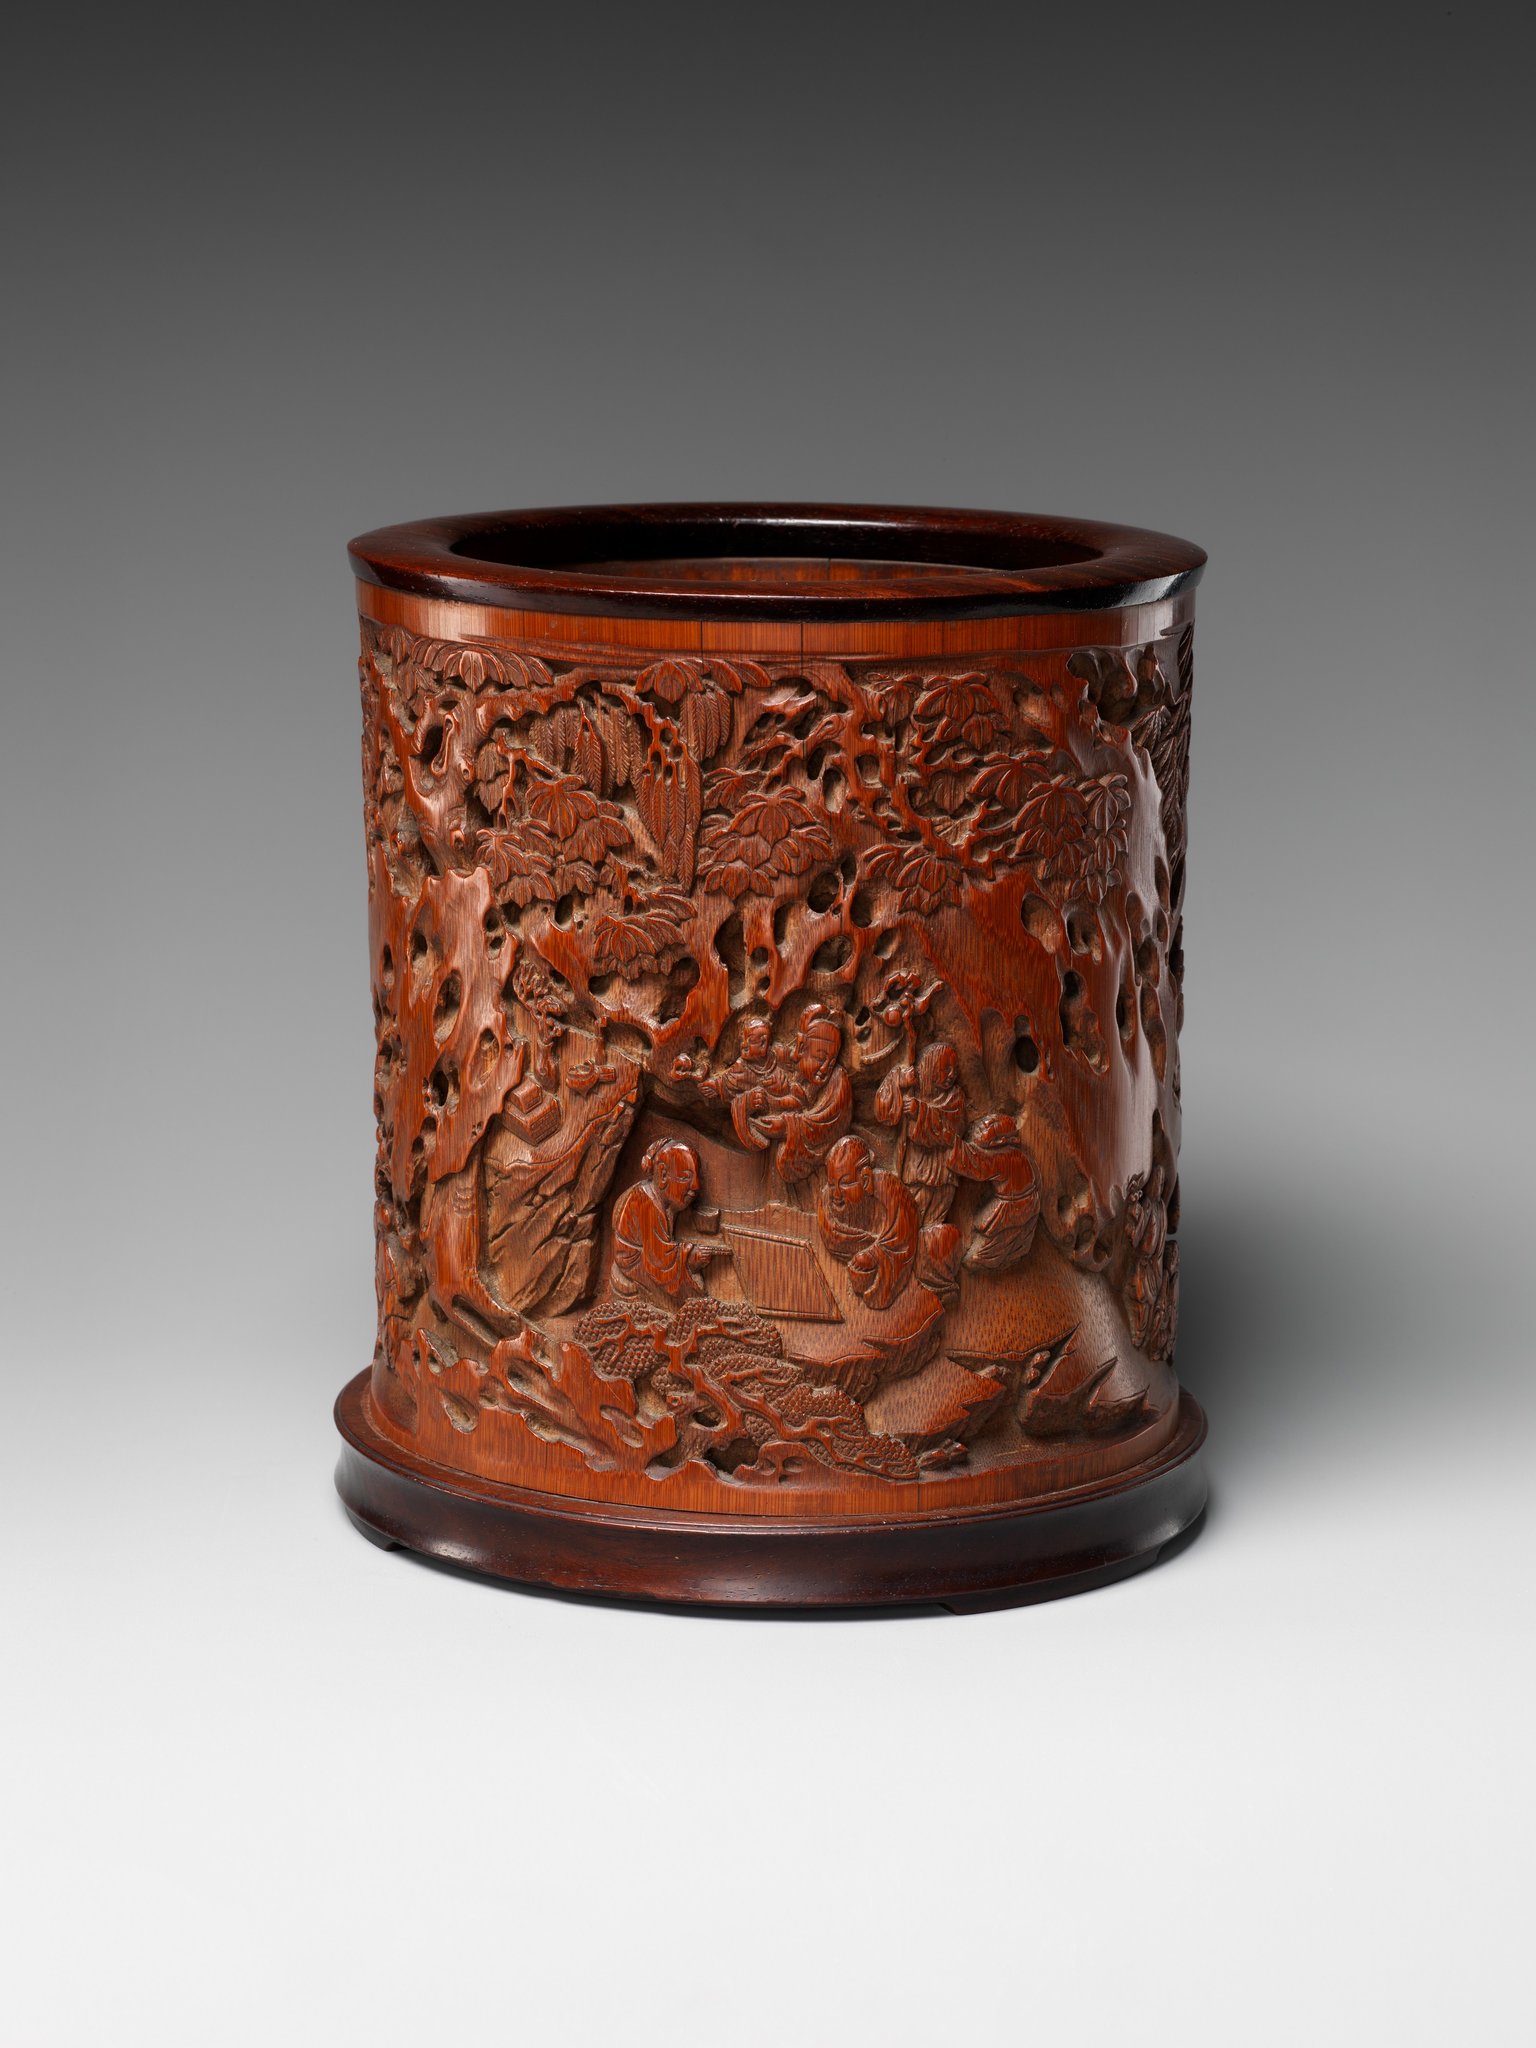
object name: brush holder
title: Brush holder decorated with garden scene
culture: chinese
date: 1662-1722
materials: bamboo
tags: men,deer,trees,games